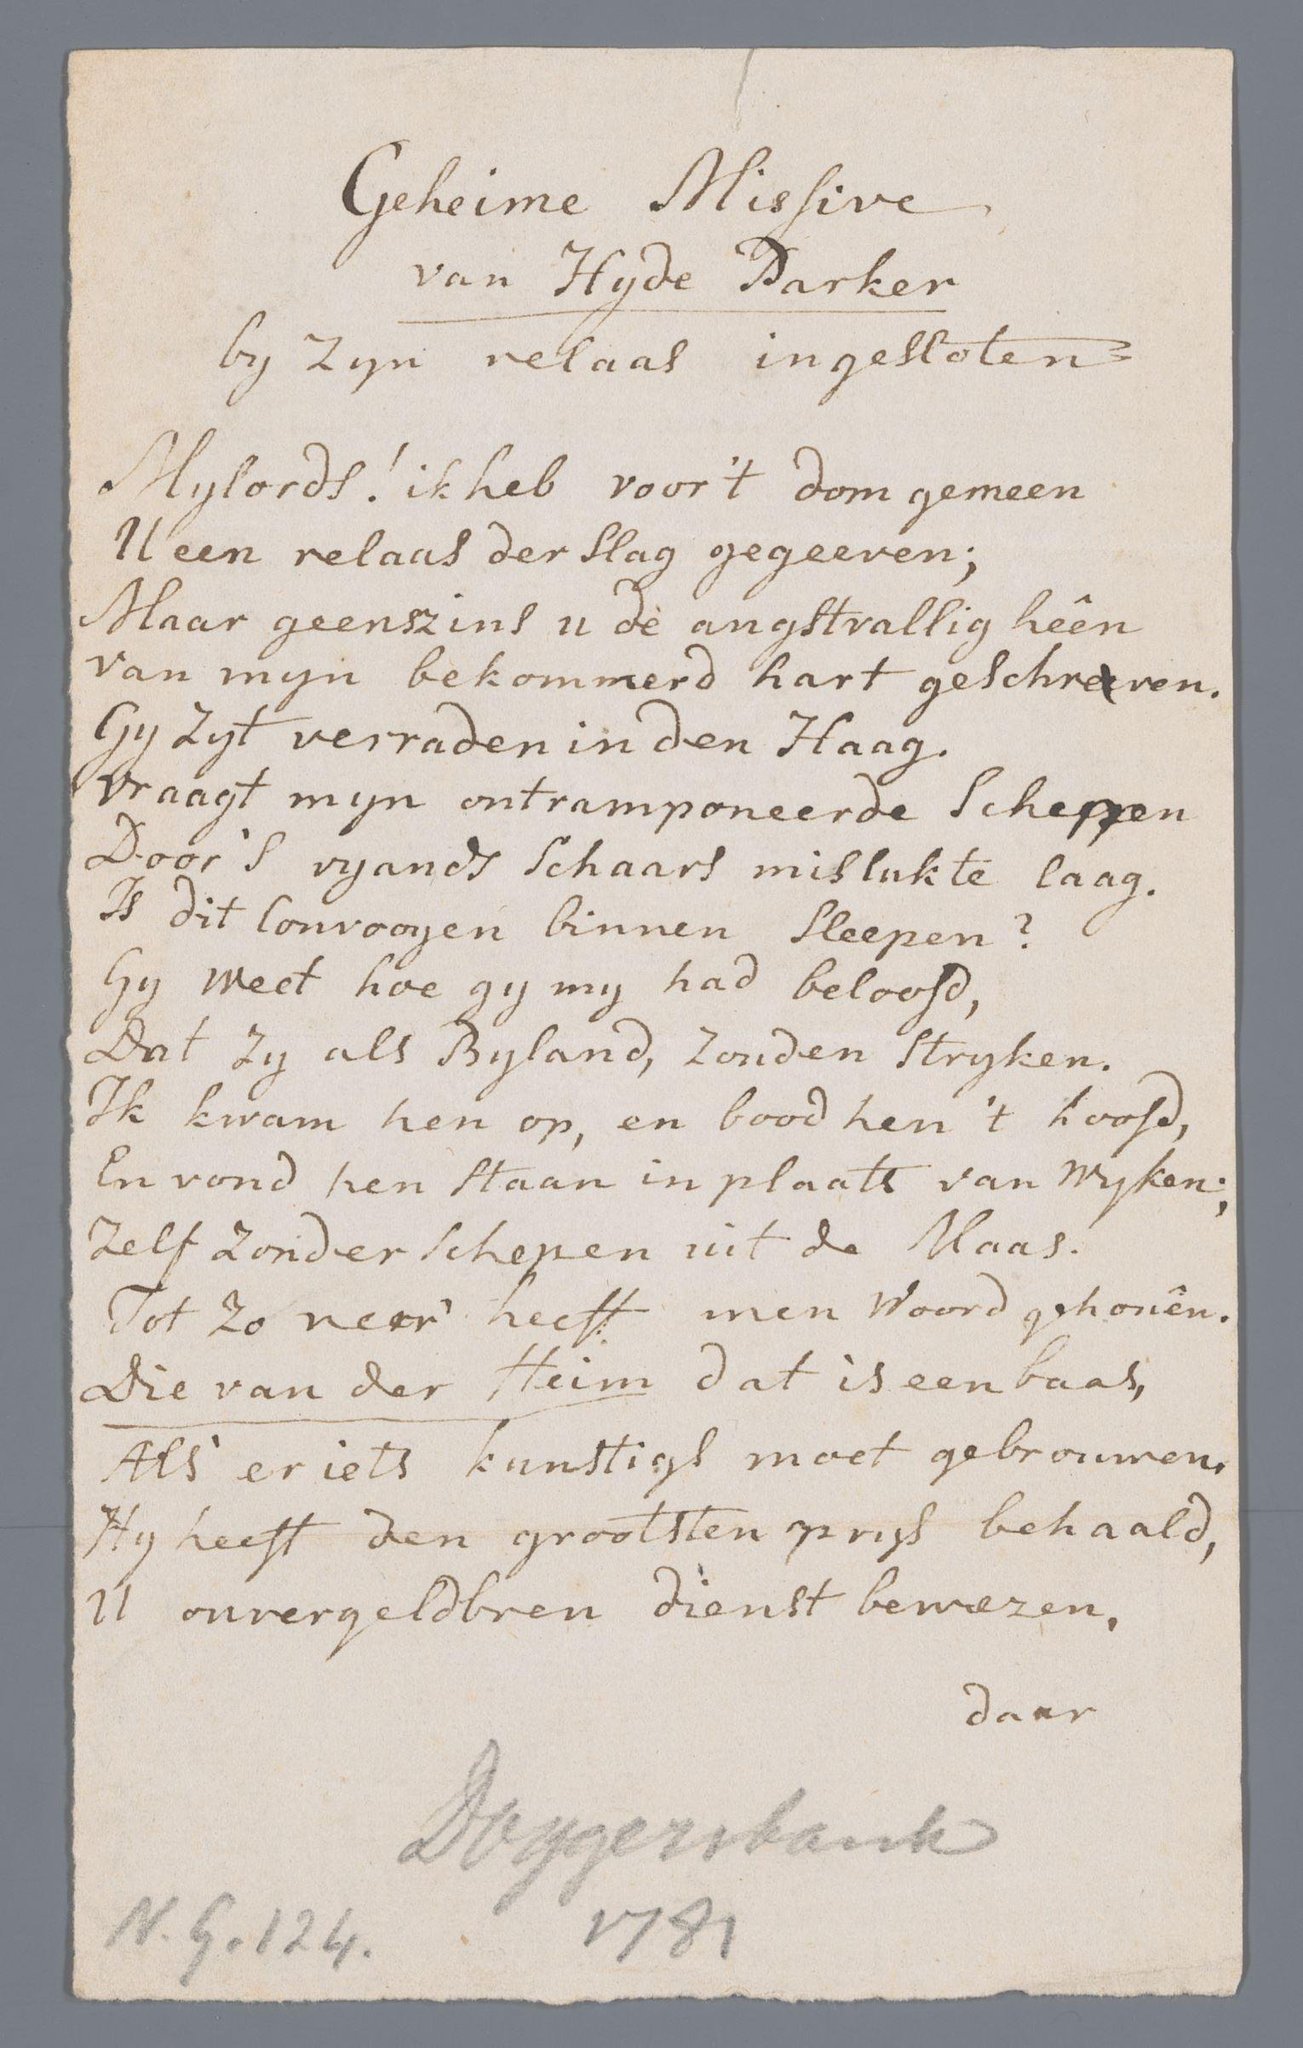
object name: manuscript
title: Geheime missive van Hyde Parker bij zijn relaas ingesloten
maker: hyde parker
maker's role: vice-admiraal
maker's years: 1714-1782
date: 1781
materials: ink, paper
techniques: writing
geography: netherlands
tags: doggersbank, zeeslag bij doggersbank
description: Handschrift op een tweezijdig beschreven vel: gedicht in de Nederlandse taal.